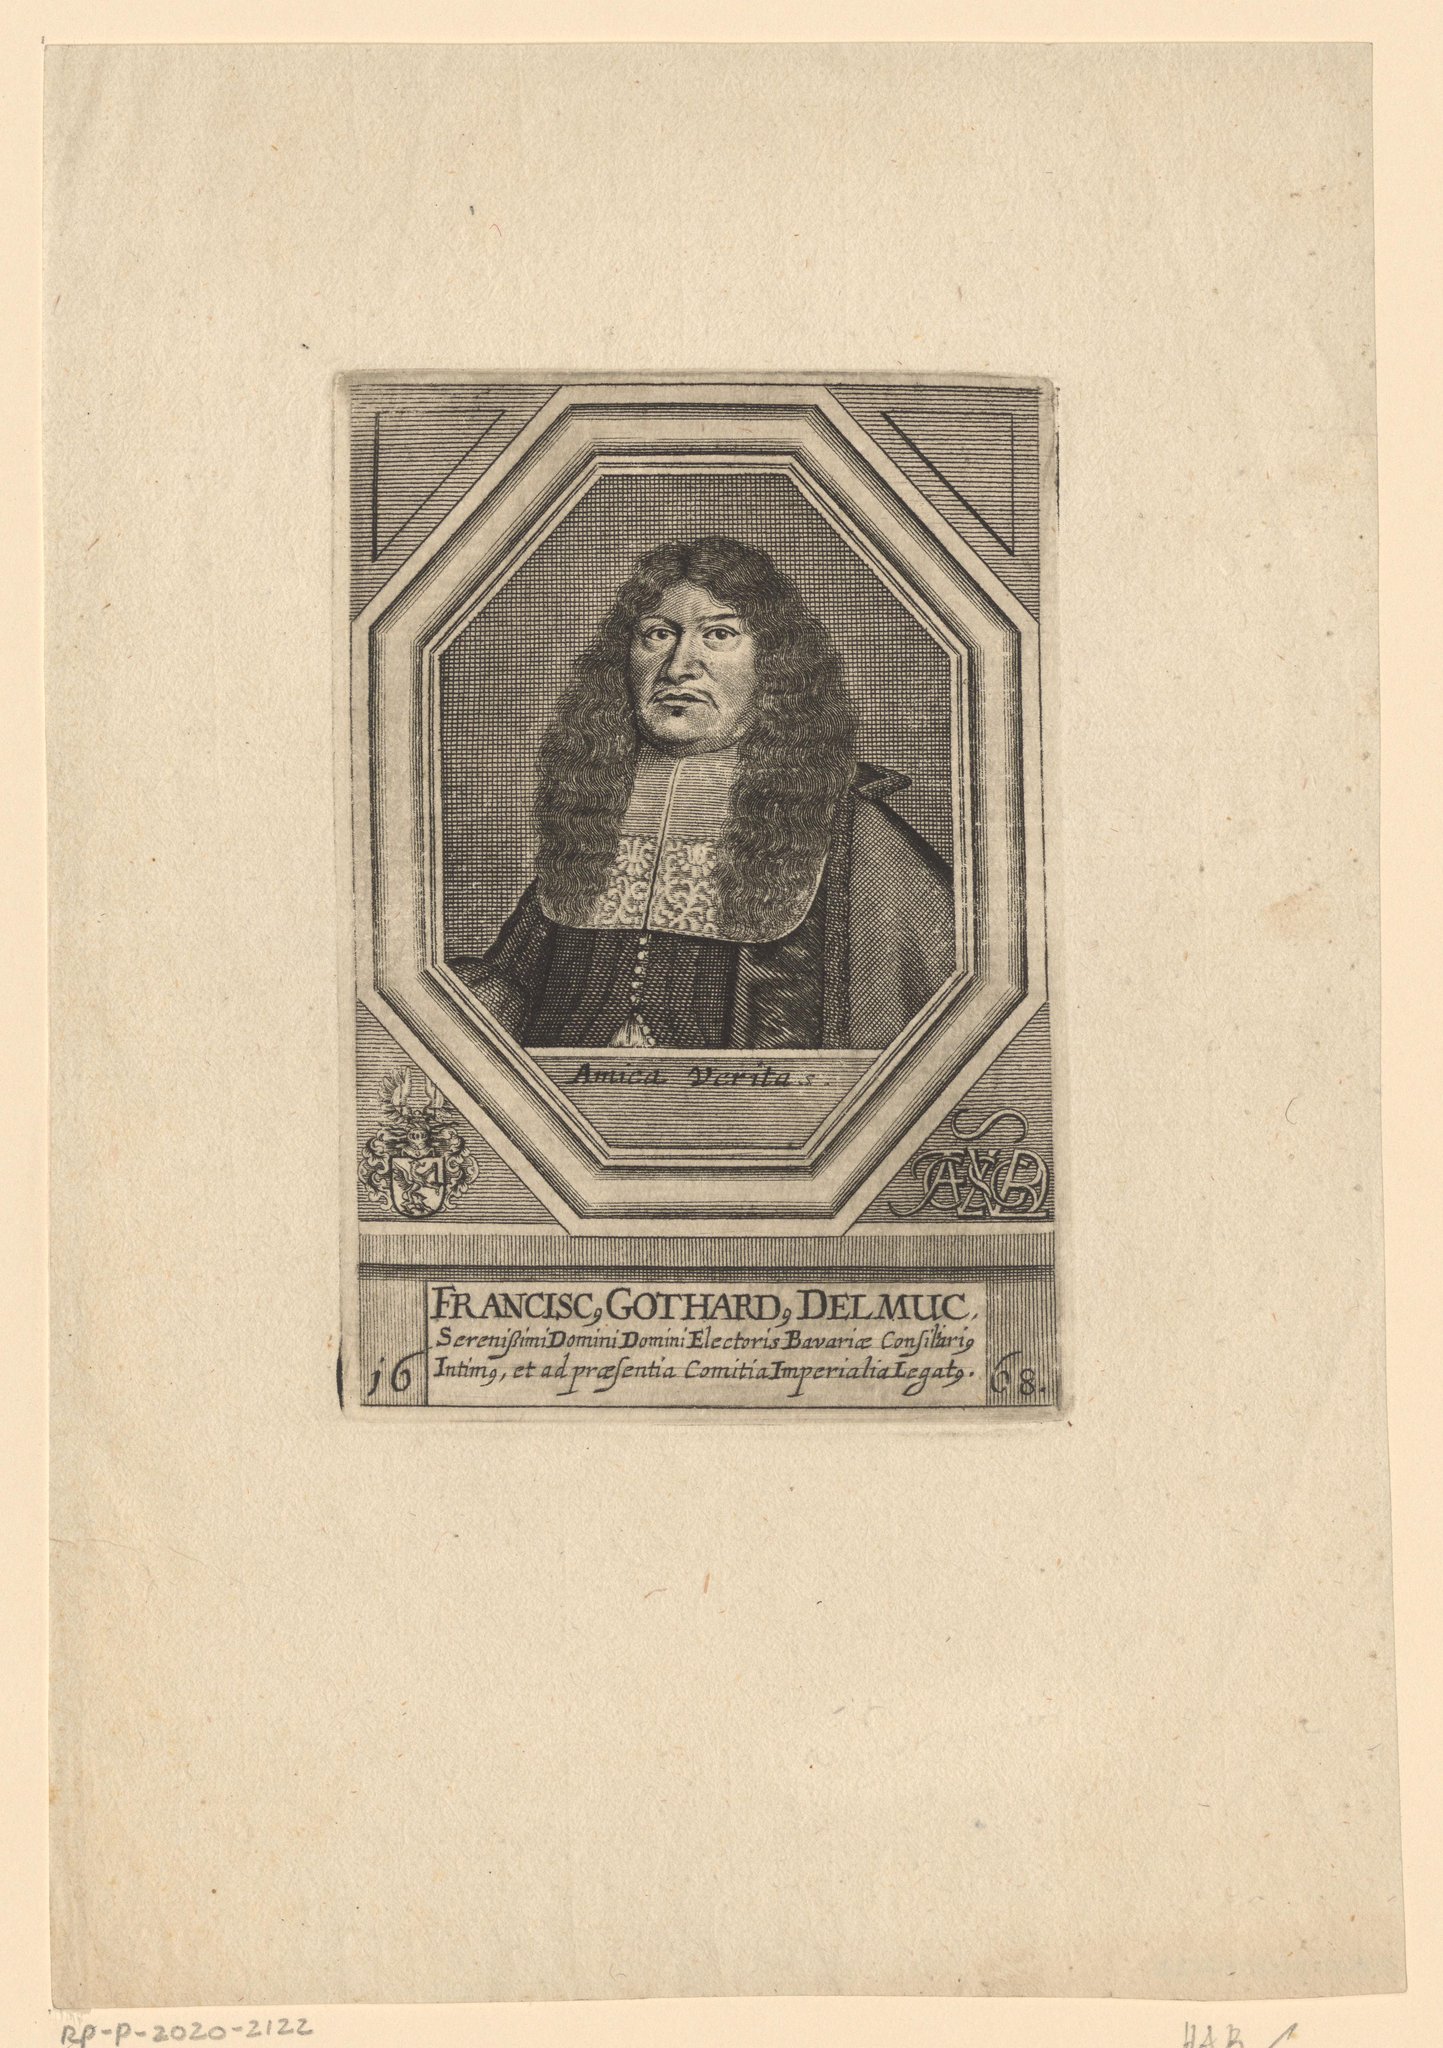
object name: print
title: Portret van Franz Gotthold Delmuc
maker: matthias van sommer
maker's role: draughtsman, print maker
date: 1668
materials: paper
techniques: engraving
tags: historical persons, diplomacy, diplomat, armorial bearing, heraldry